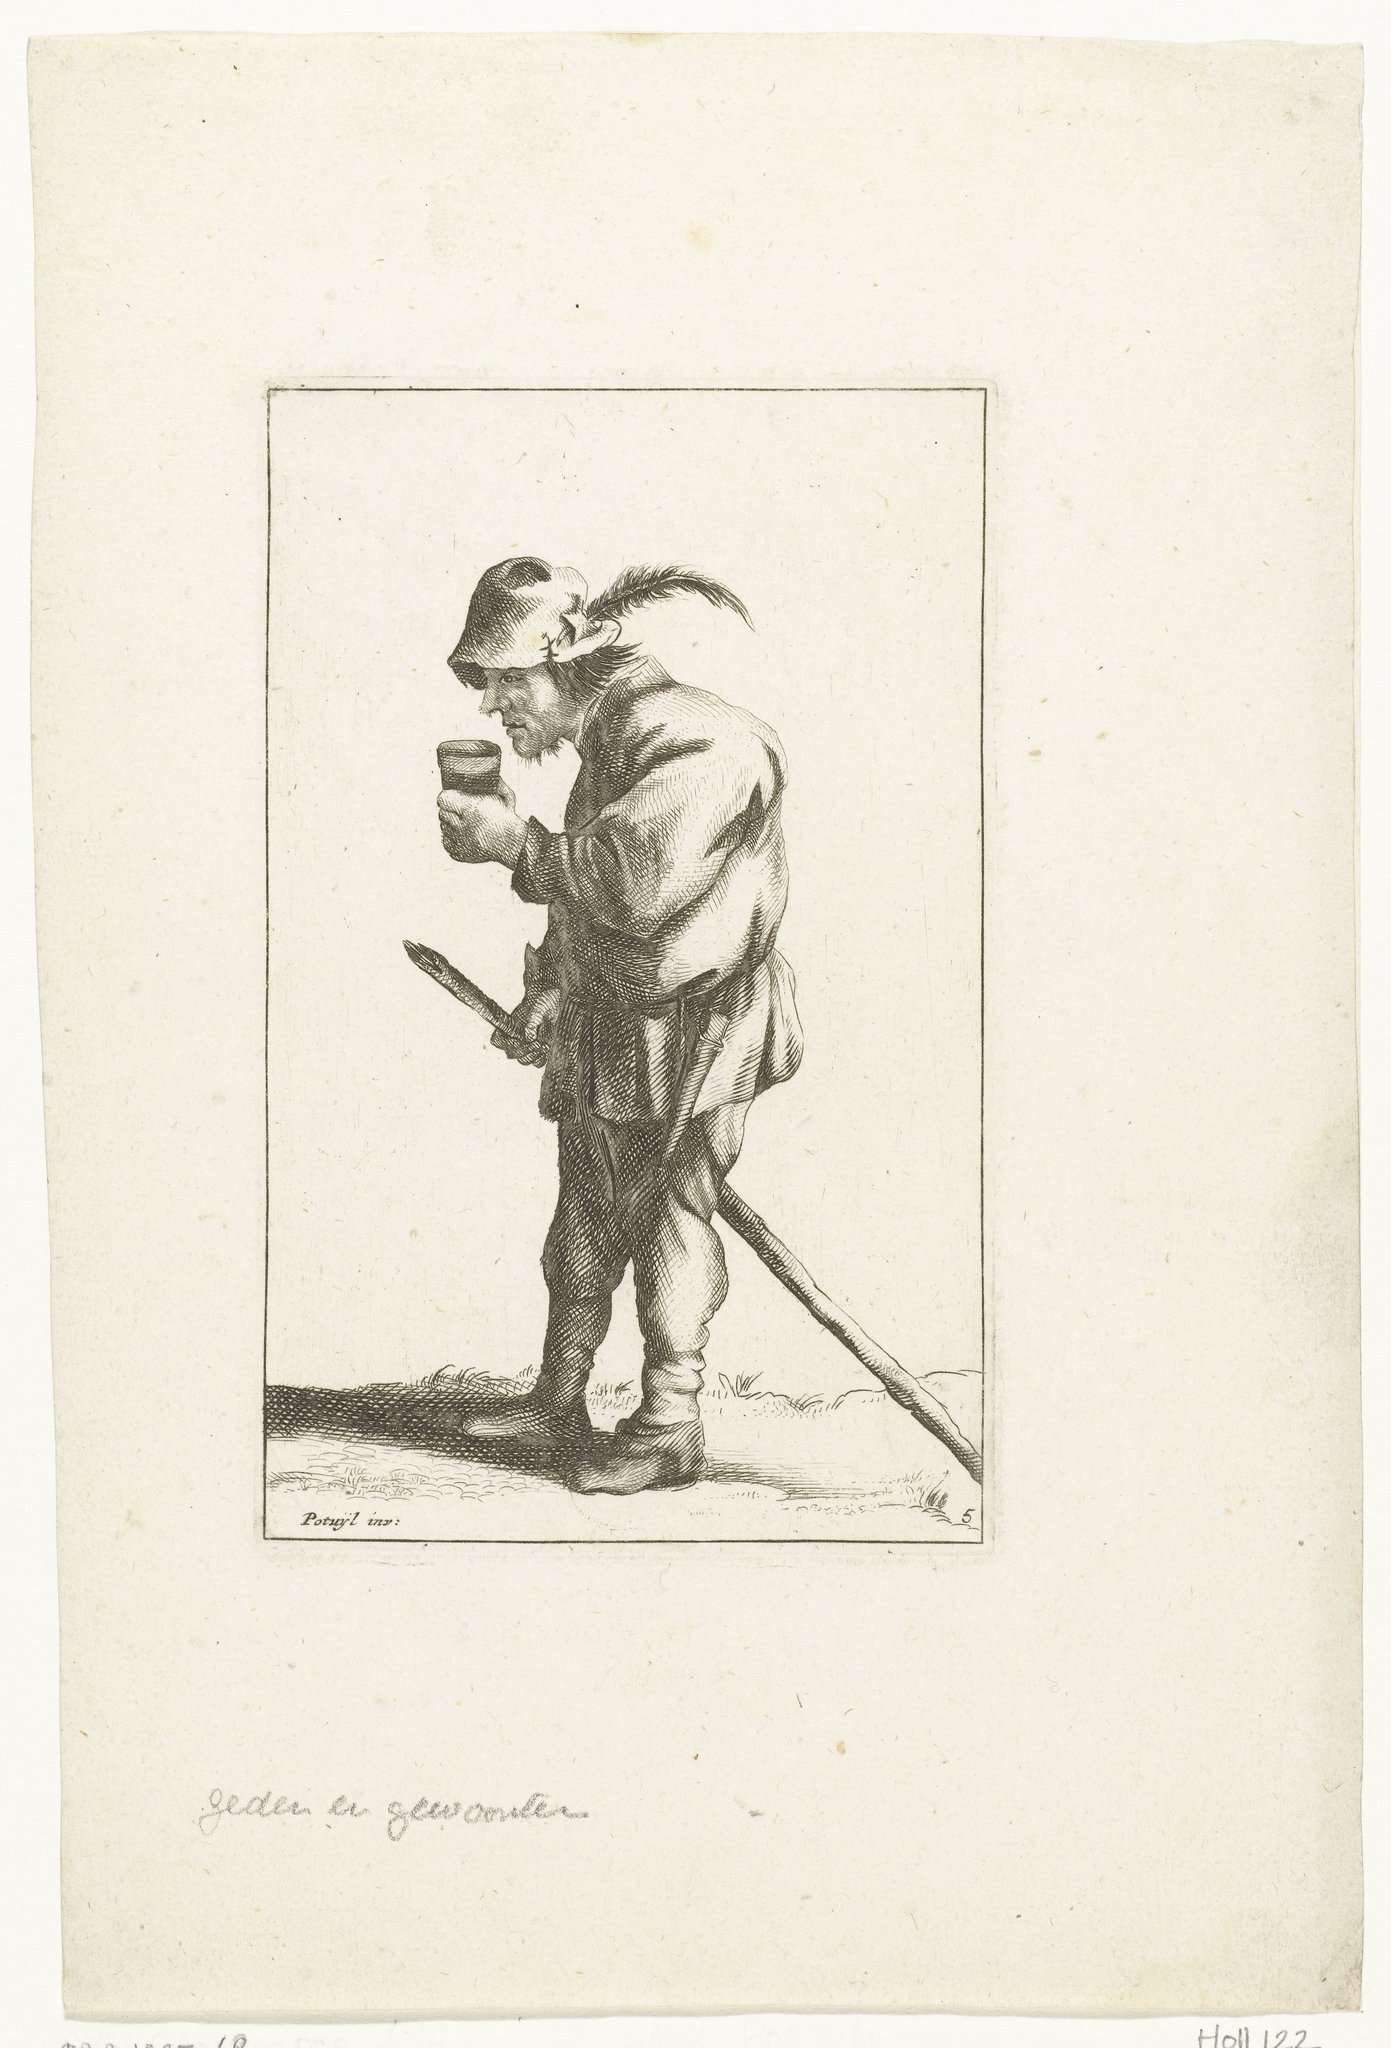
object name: print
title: Enige boeren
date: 1613-1656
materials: paper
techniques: etching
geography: netherlands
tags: farmers, glass, rummer, drinking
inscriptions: collector's mark: Lugt 2228, collector's mark: Lugt 2233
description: Prent uit serie van zes prenten met boeren naar verschillende kunstenaars: Jan Miense Molenaer, Pieter Quast, Hendrik Potuyl en Adriaen van Ostade